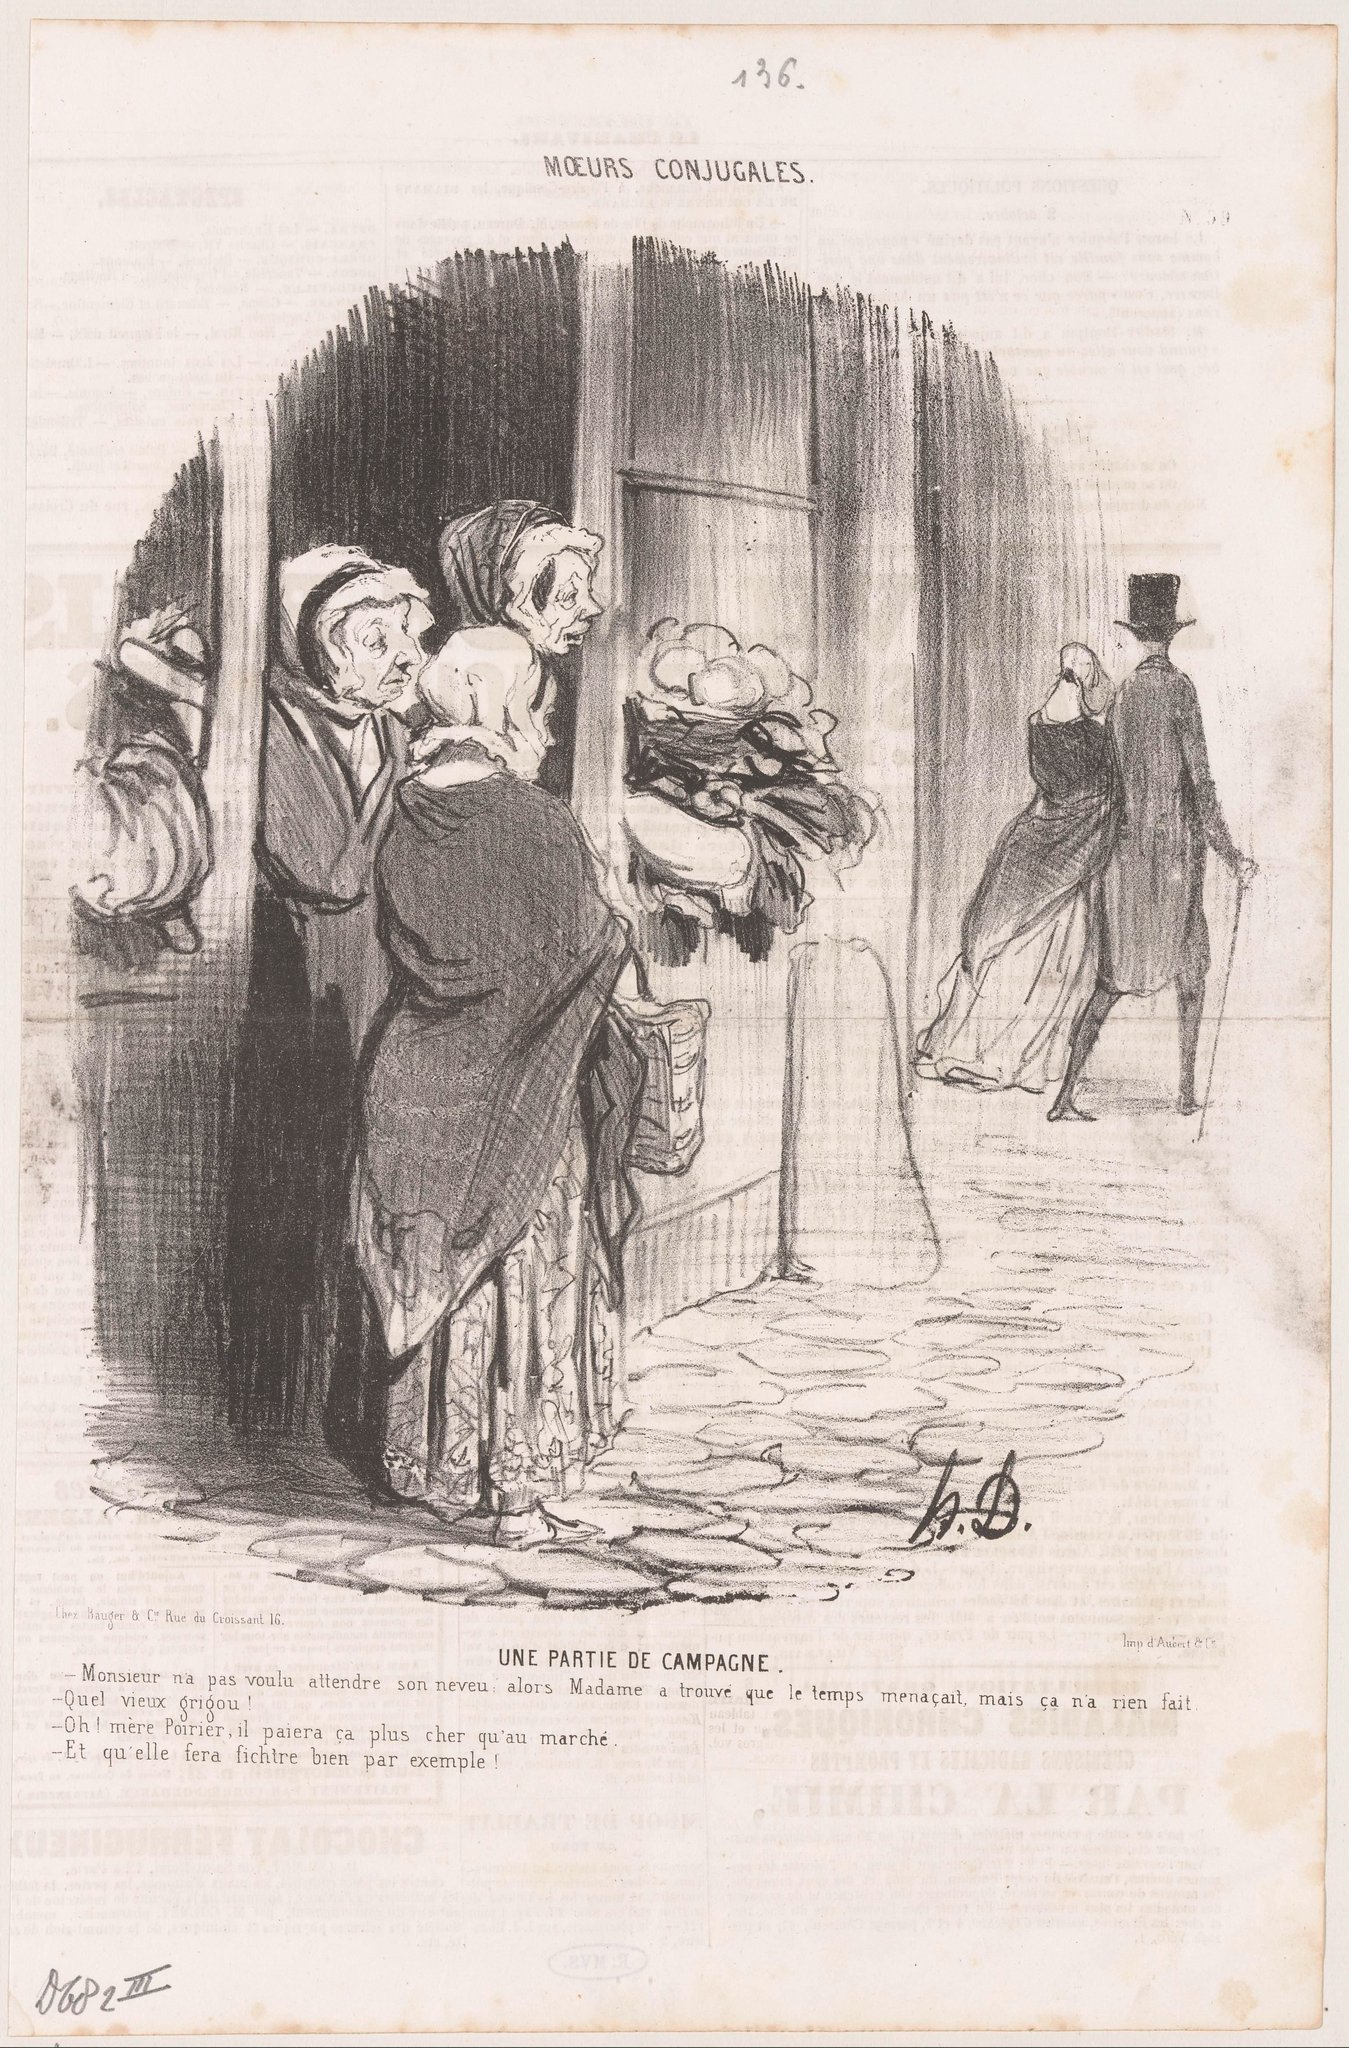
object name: cartoon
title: Moeurs conjugales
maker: honoré daumier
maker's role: draughtsman, painter, print maker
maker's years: 1808-1879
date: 1842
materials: paper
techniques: letterpress printing, lithograph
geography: paris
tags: caricatures (human types), old woman, speaking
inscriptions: collector's mark: Lugt 2228a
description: Prent mogelijk uit: Le Charivari, 2 oktober 1842.